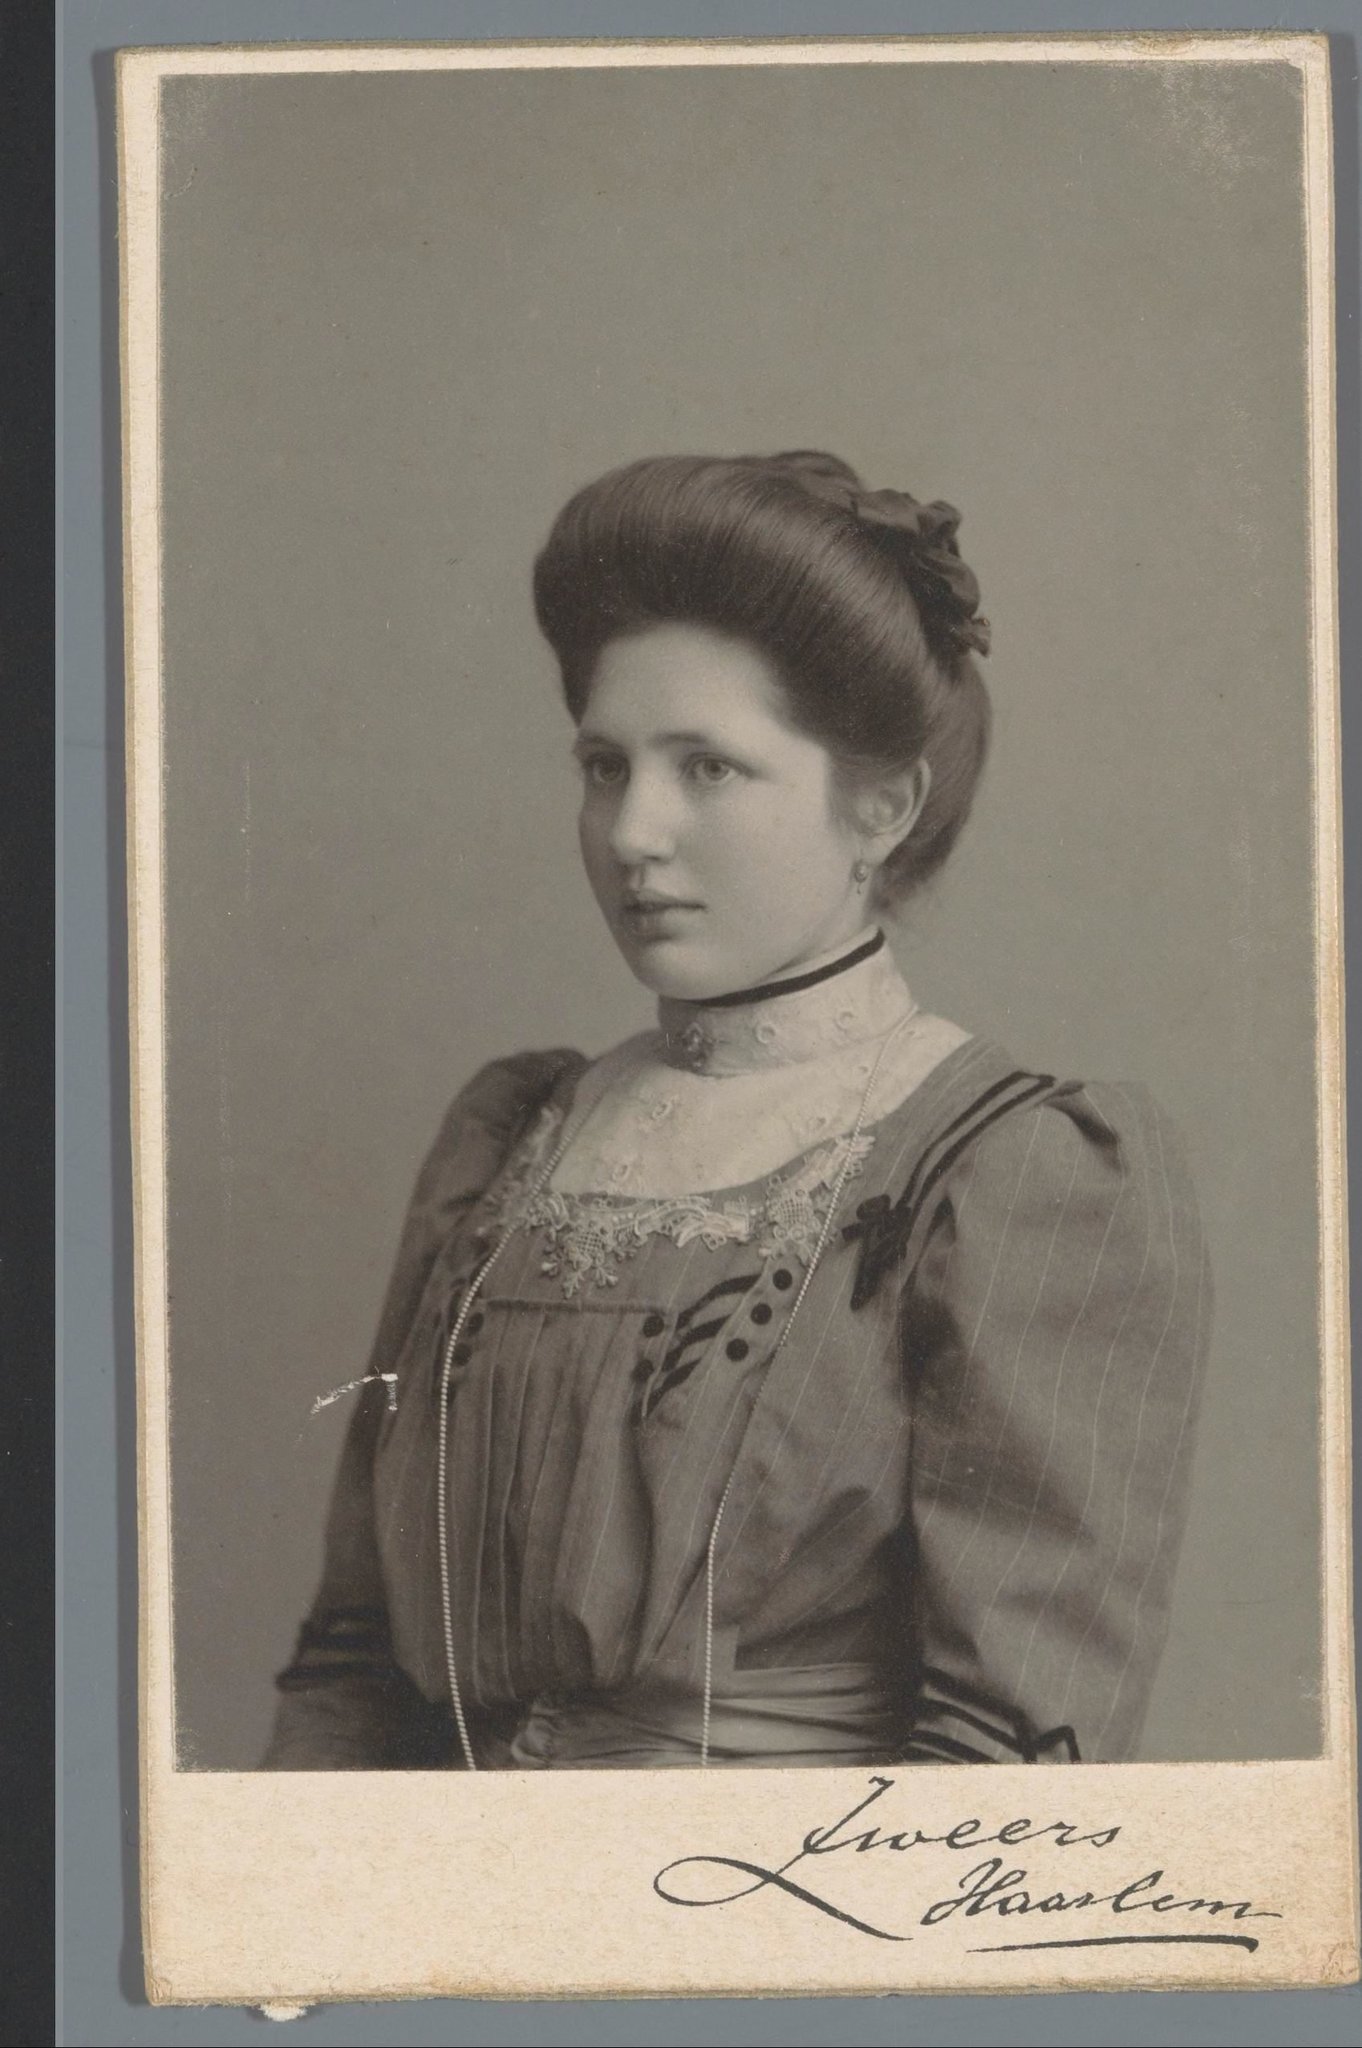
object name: carte de visite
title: Portret van een onbekende jonge vrouw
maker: berend zweers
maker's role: fotograaf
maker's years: 1872-1946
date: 1923-1934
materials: paper, cardboard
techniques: gelatin silver print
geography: haarlem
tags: adolescent, young woman, maiden, anonymous historical person portrayed, haarlem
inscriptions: inscription: ‘B. Zweers/ Groote Houtstraat 174/ Haarlem/ Telefoon 1669/ Onderscheidingen/ Amsterdam 1895/ Turijn 1902/ 's Gravenhage 1906/ Leeuwarden 1906/ Leiden 1907/ Harlingen 1908/ Zeist 1908/ 's Gravenhage 1908/ Amsterdam 1908/ Dresden 1909’, inscription: ‘Zweers/ Haarlem’